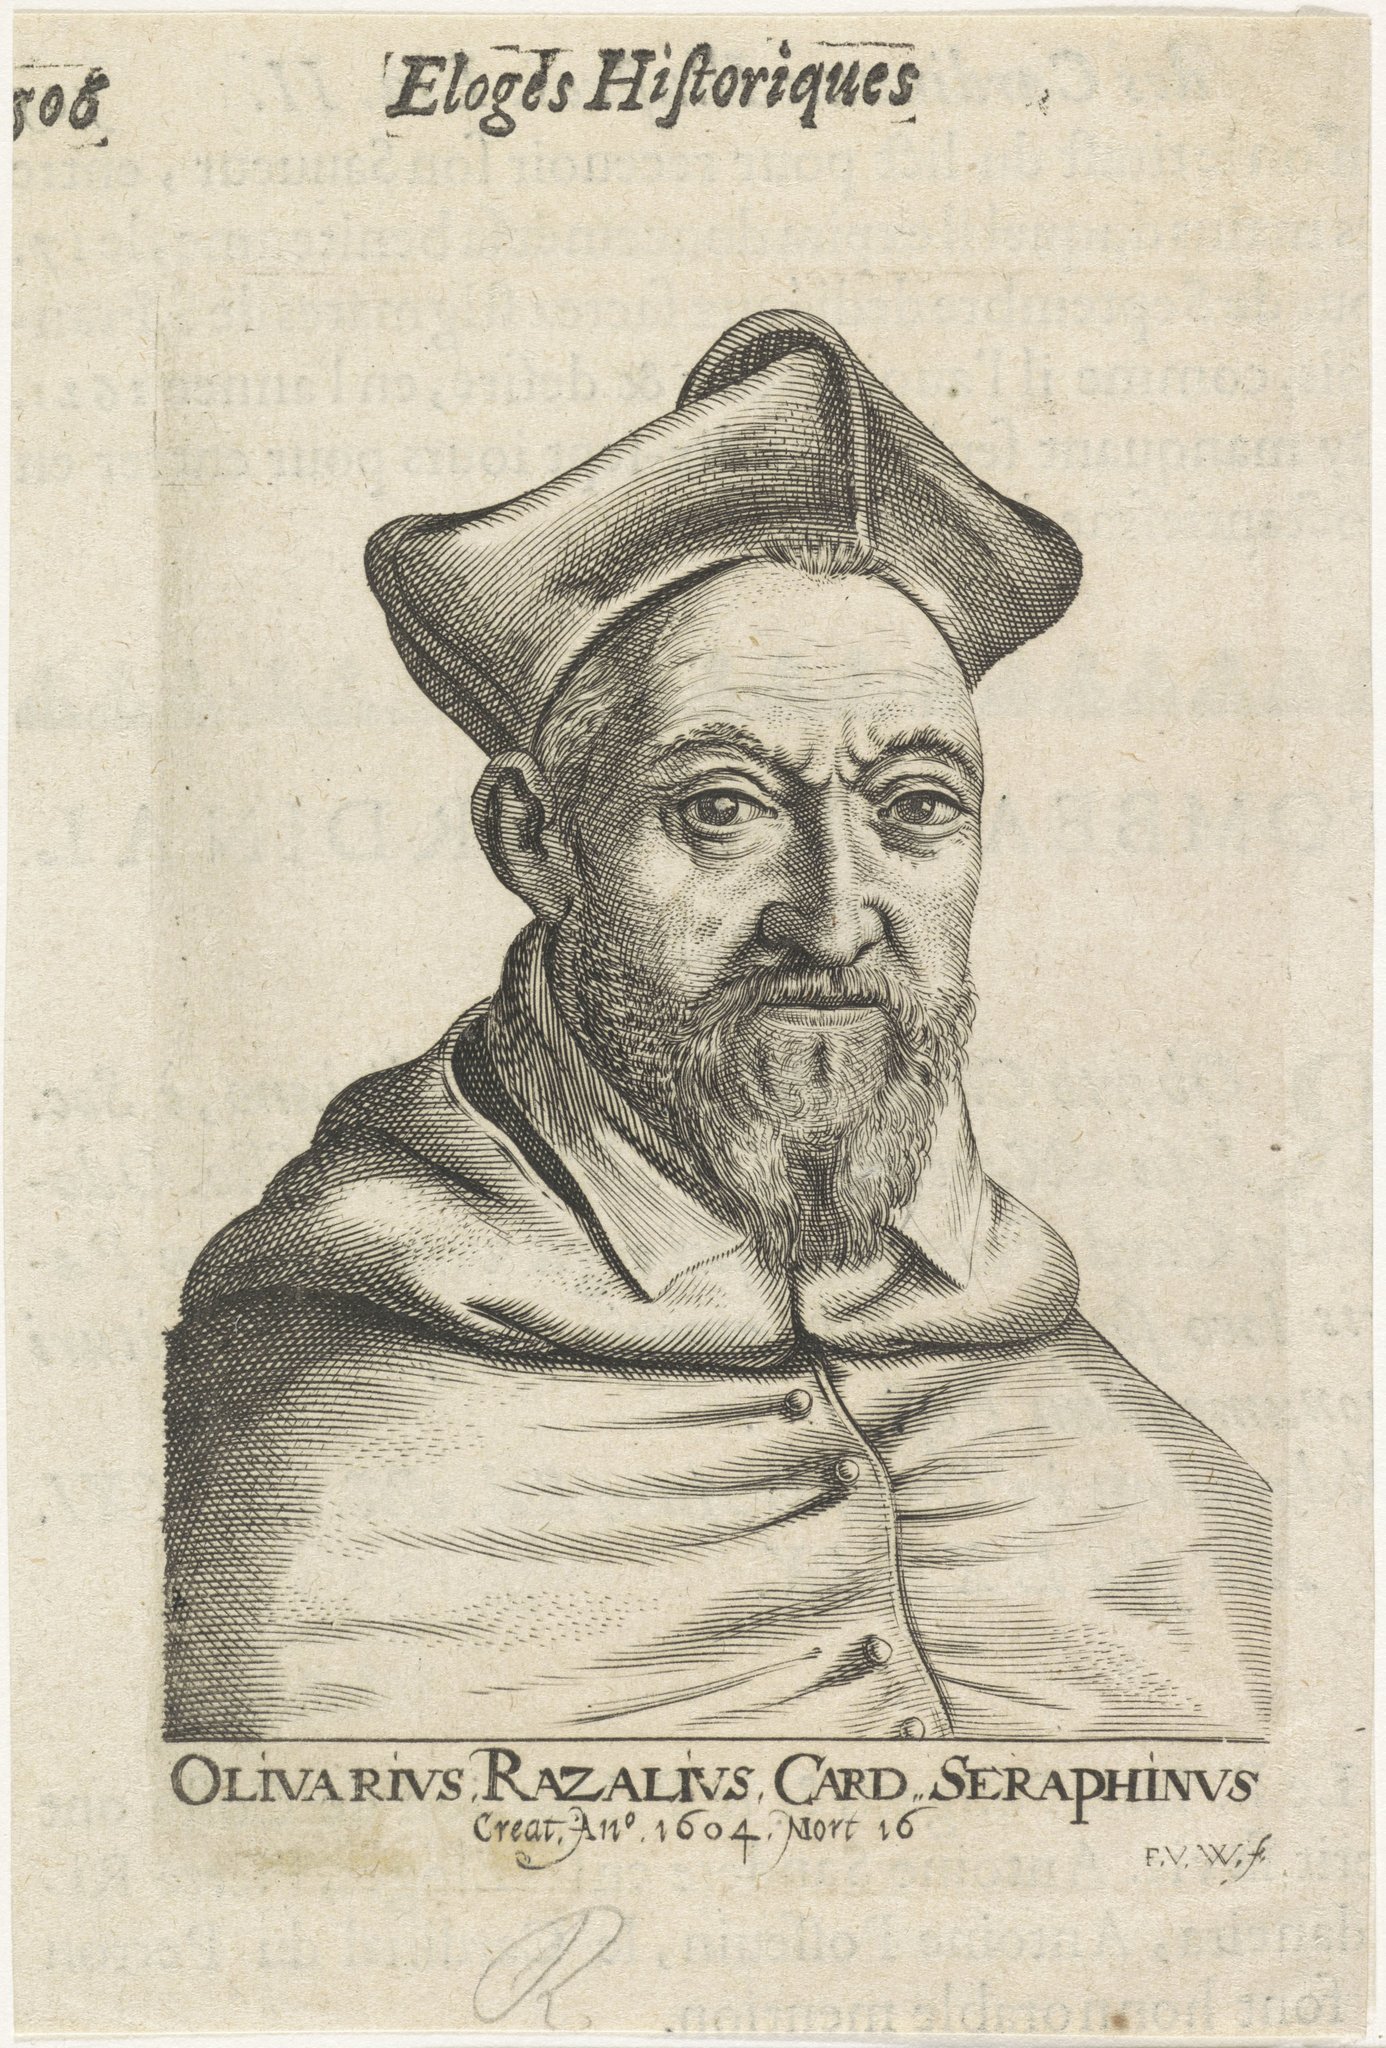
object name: book illustration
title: Portret van de Franse kardinaal Séraphin Olivier-Razali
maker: frans van den wijngaerde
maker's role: print maker, publisher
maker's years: 1614-1679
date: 1644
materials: paper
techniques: engraving, letterpress printing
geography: antwerp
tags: lyon, rome, cardinal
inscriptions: collector's mark: Lugt 2228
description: Prent uit: Albi, Henri. Eloges historiques des Cardinaux illustres François et etrangers mis en parallele. Parijs: Anthoine de Cay, 1644.